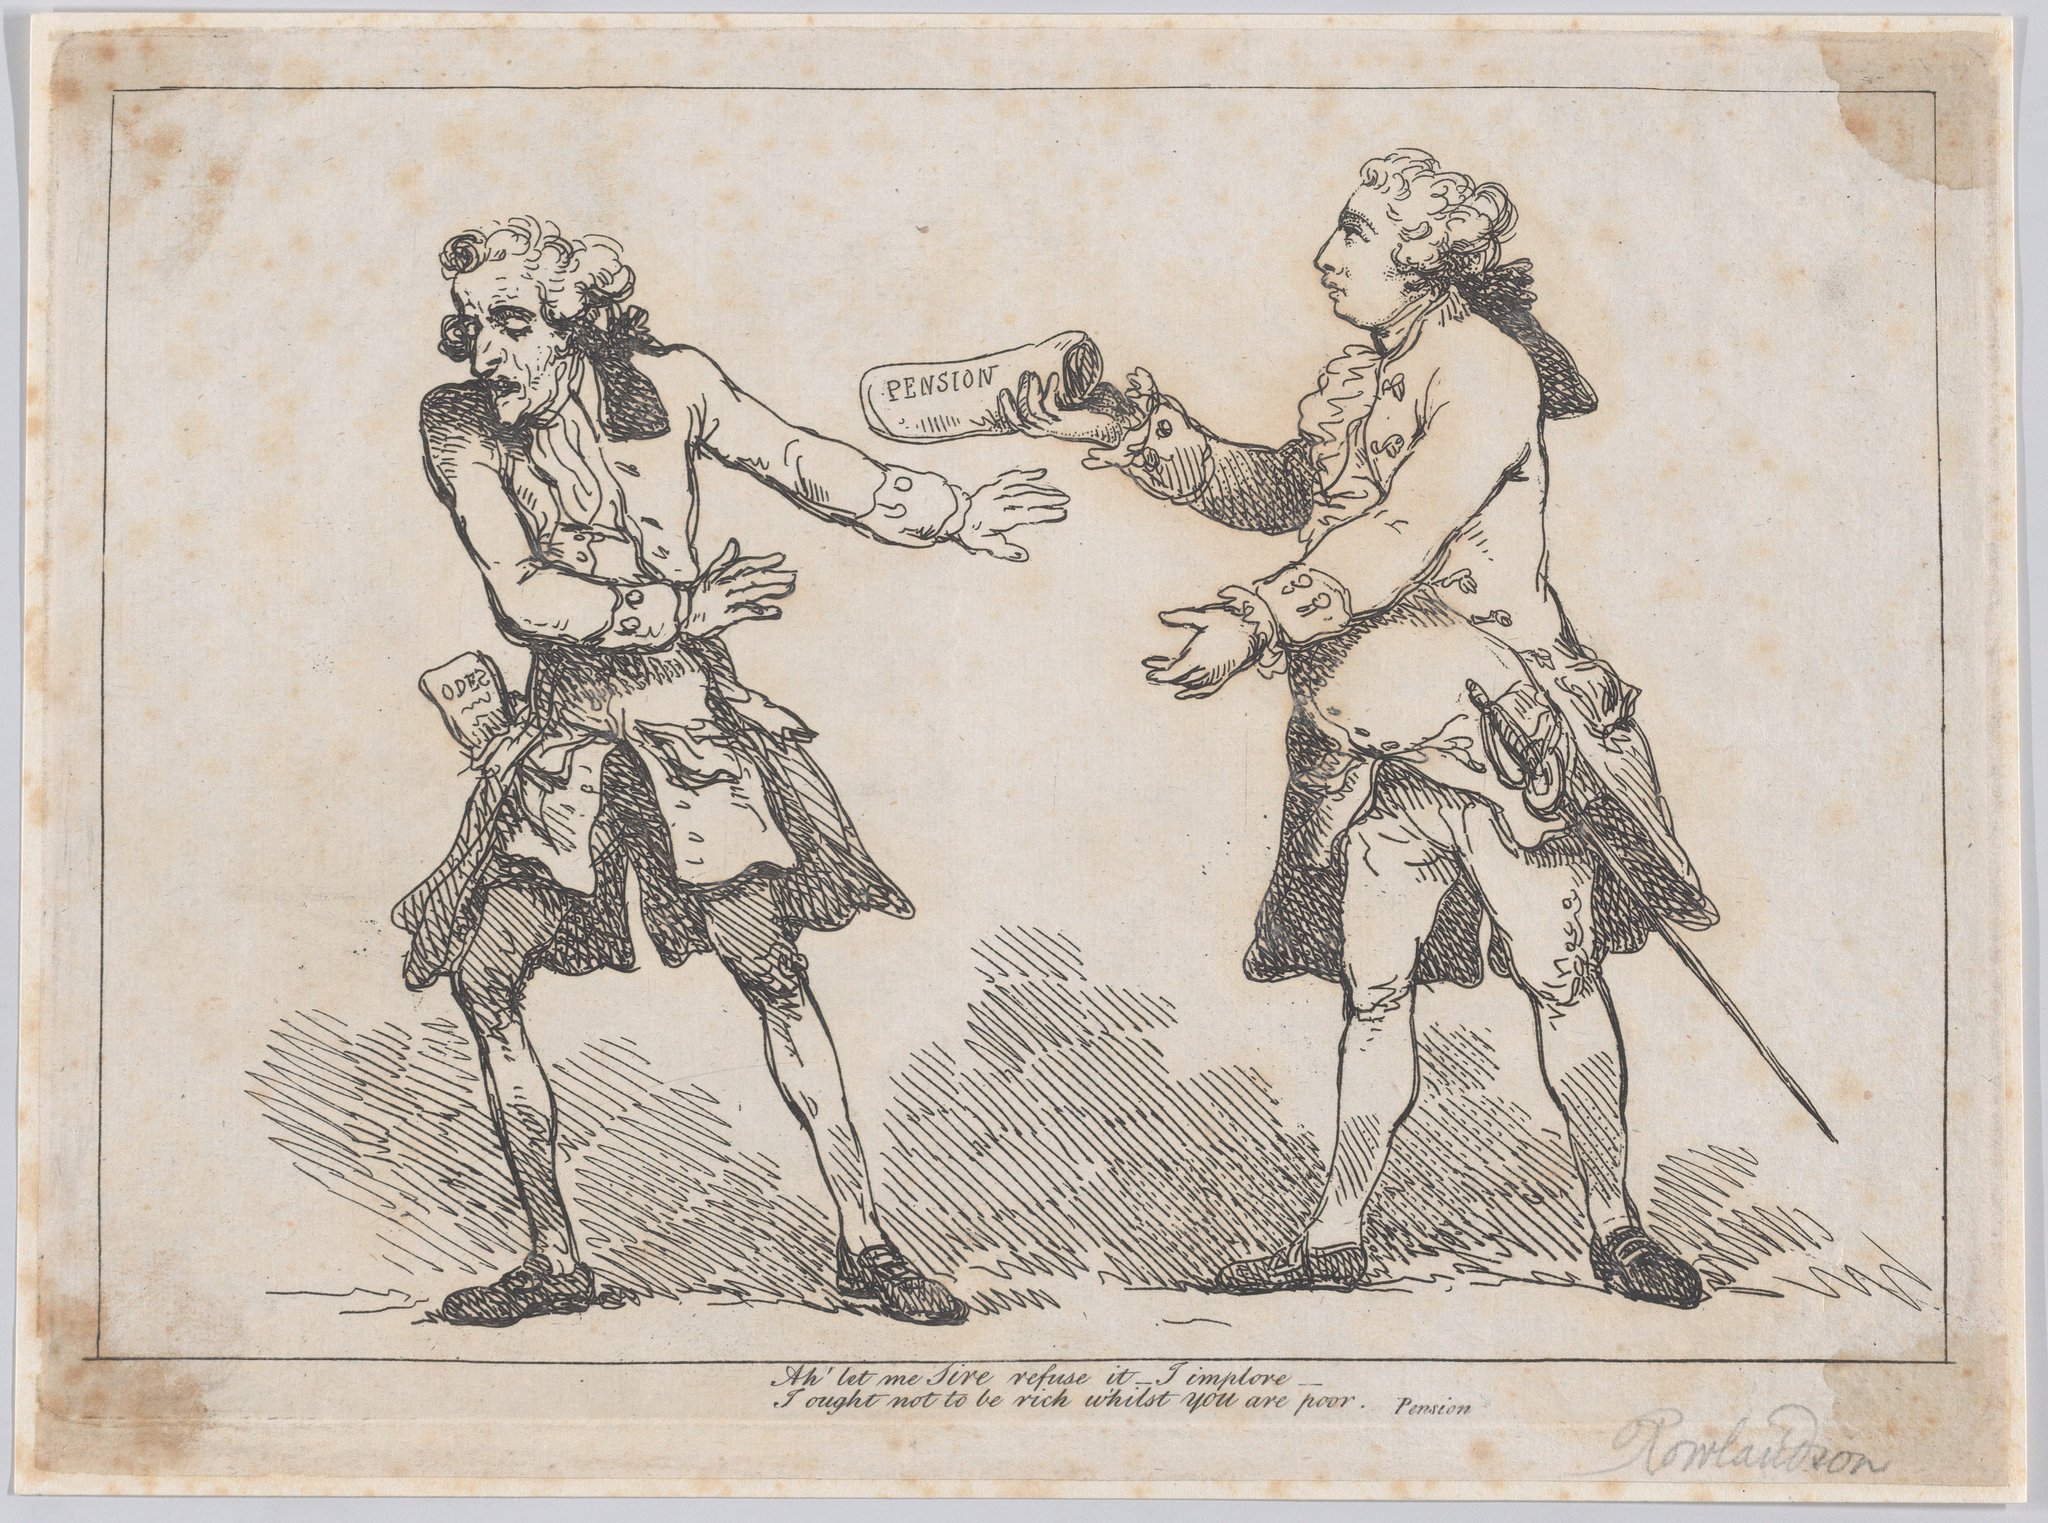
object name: print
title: Ah' let me Sire refuse it..., from Peter's Pension by Peter Pindar, Esq.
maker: thomas rowlandson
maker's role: artist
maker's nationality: british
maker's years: 1757-1827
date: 1787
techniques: etching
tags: satire,men